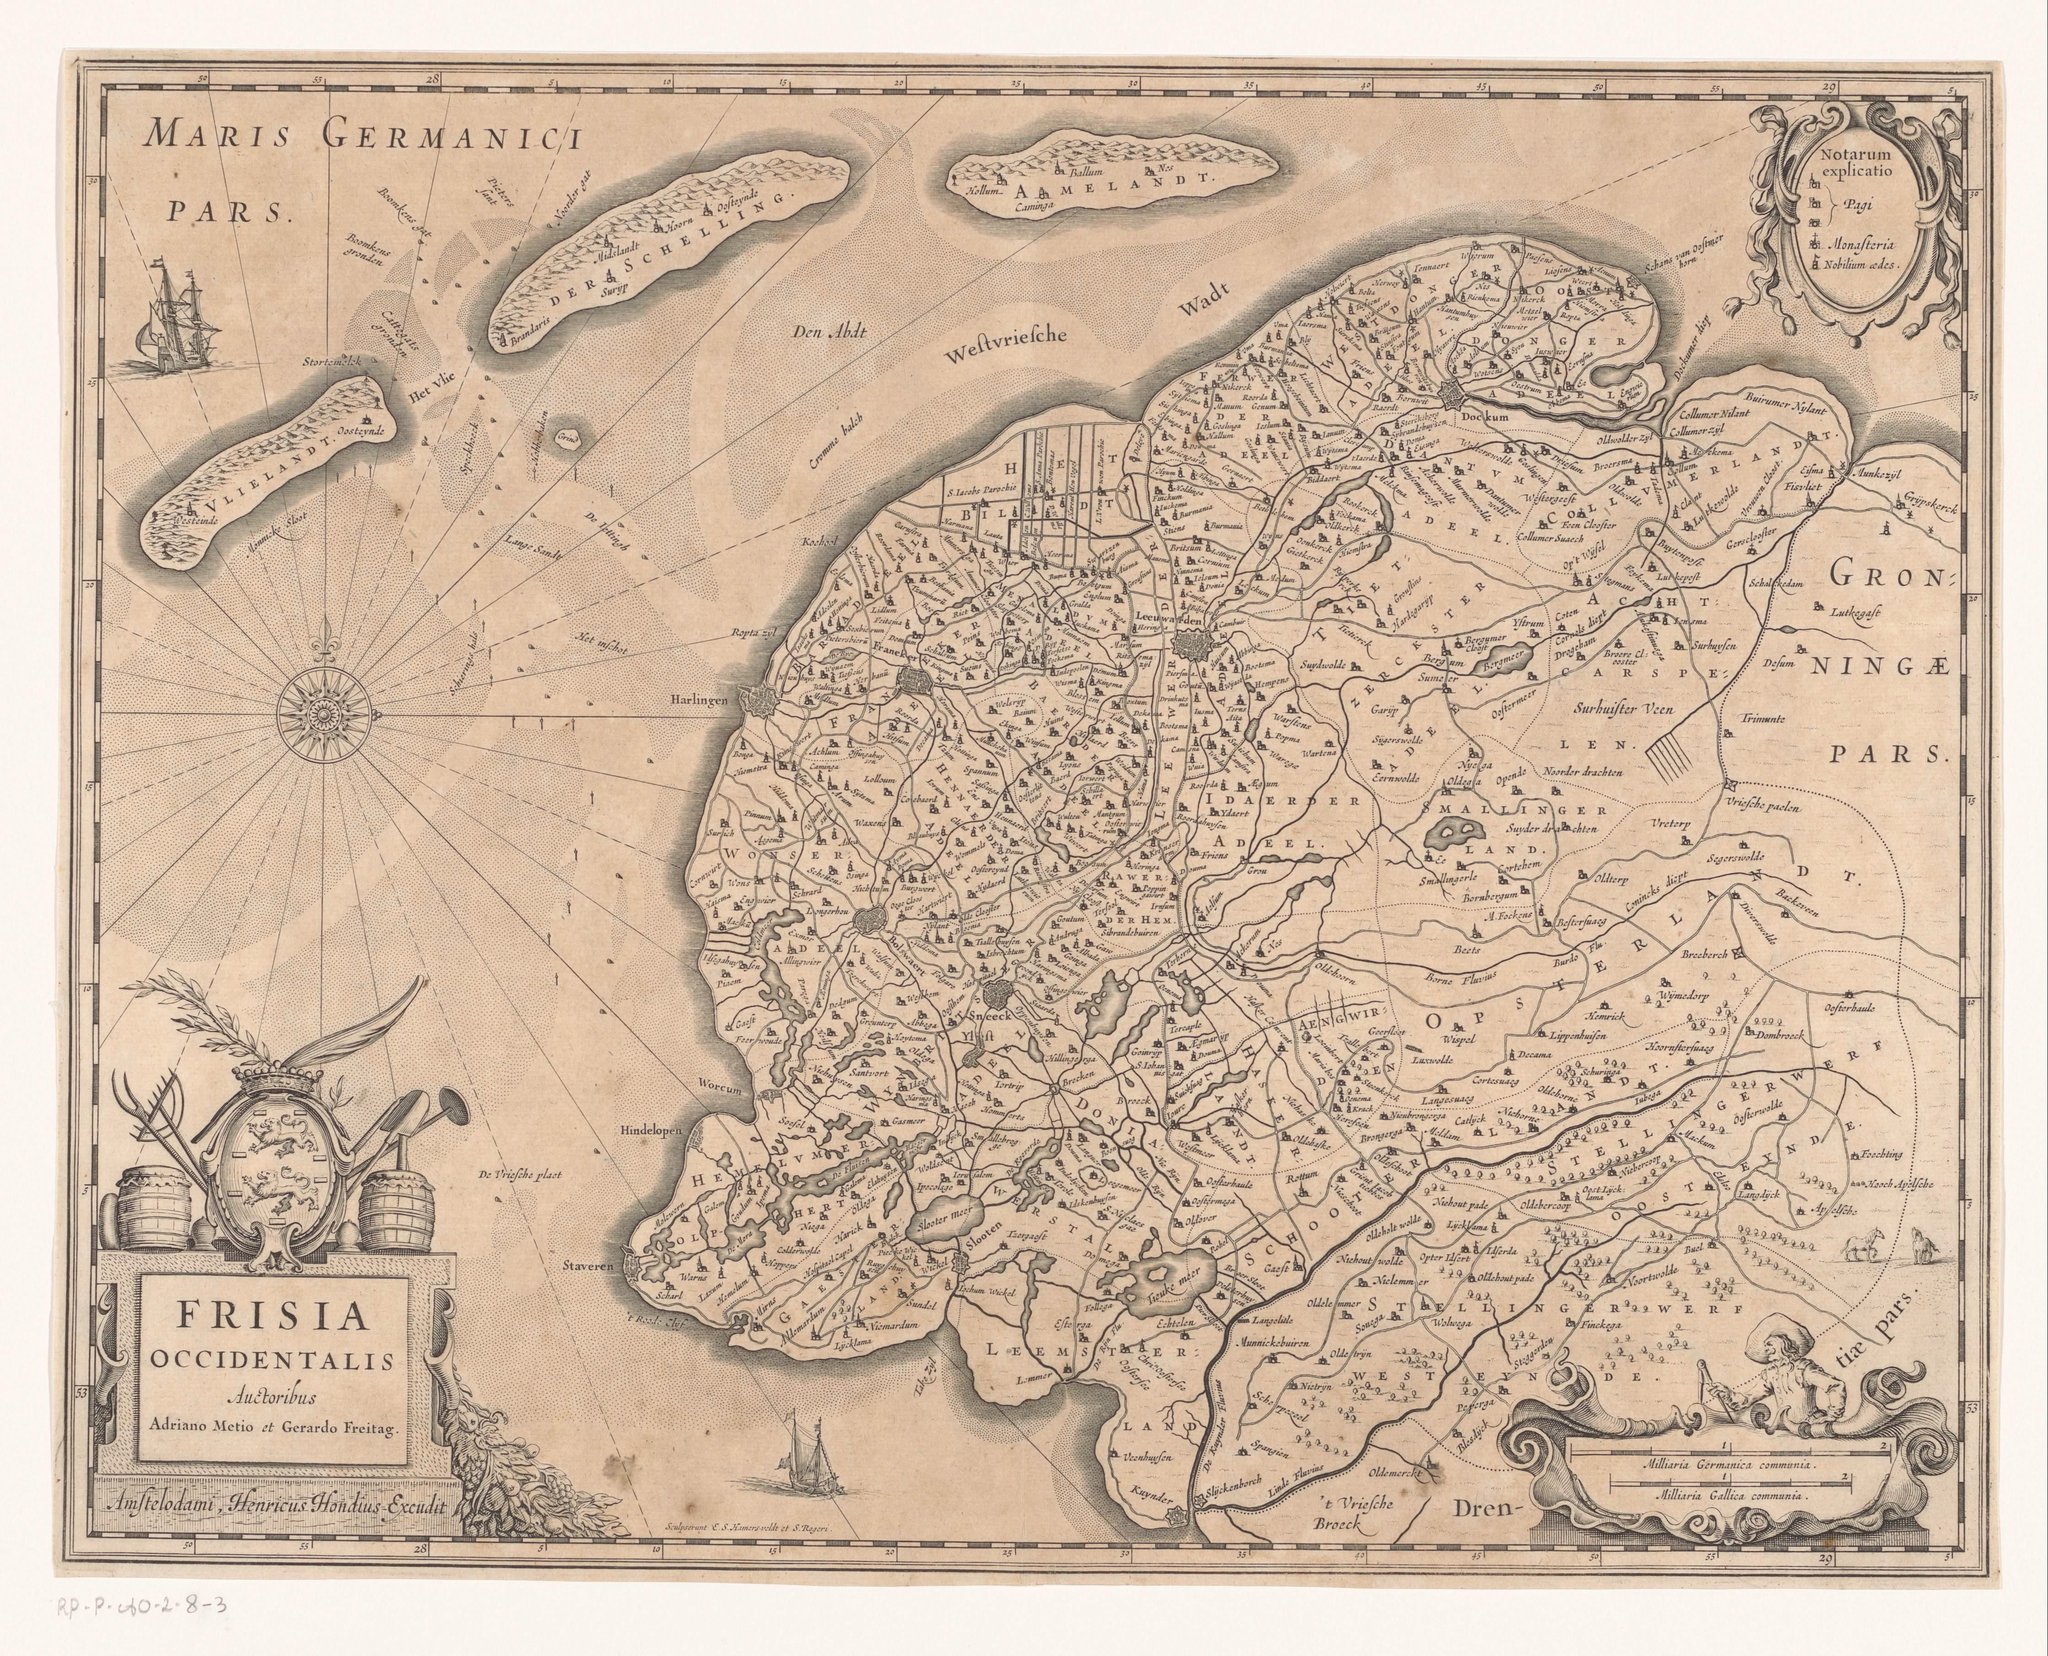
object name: print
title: Frisia Occidentalis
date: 1630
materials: paper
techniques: engraving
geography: amsterdam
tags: coat of arms (as symbol of the state, etc.), maps of separate countries or regions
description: Linksonder titelcartouche met daarboven het wapen van Friesland. Rechtsboven legenda, rechtsonder twee schaalstokken: Milliaria Germanica communia, Milliaria Gallica communia. Daarboven een manfiguur met een passer. Gradenverdeling langs de randen.